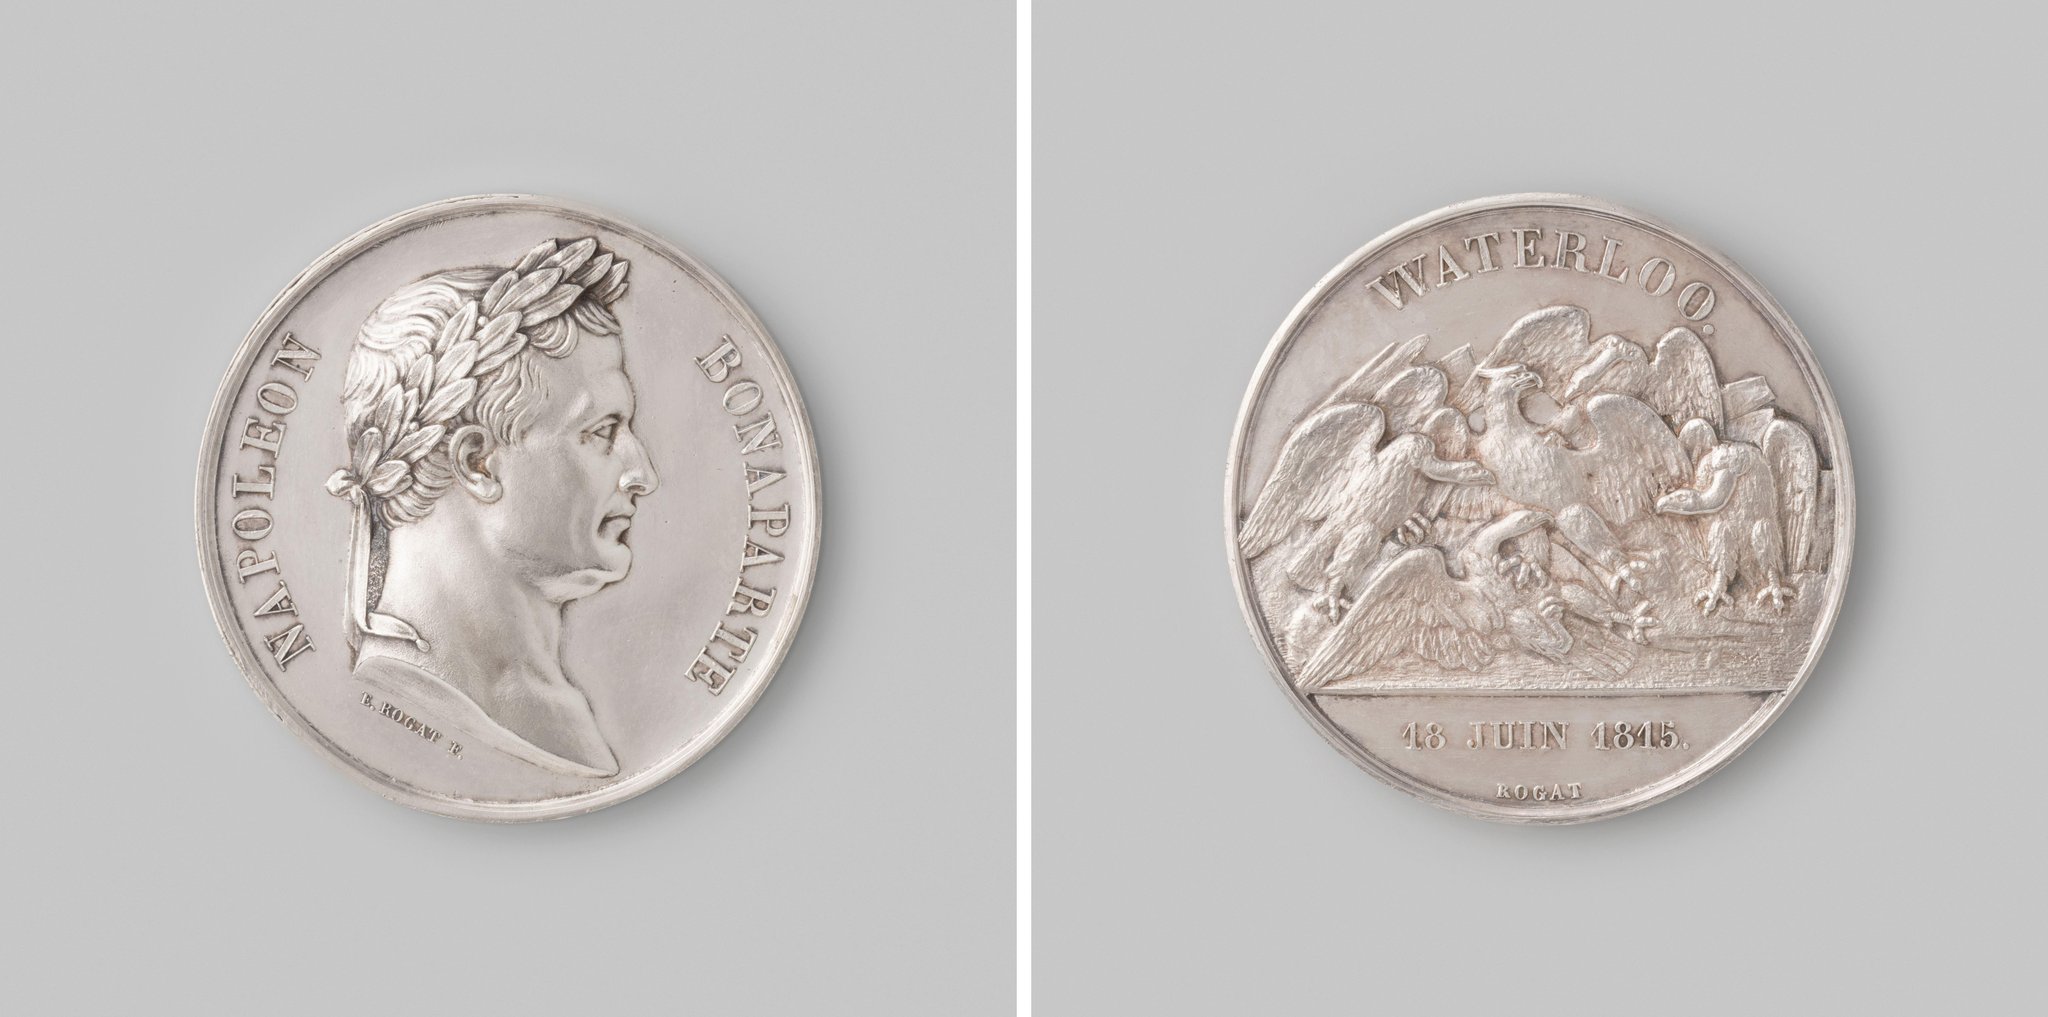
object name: history medal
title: Slag bij Waterloo, ter ere van Napoleon I Bonaparte, keizer der Fransen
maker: emile rogat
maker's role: medailleur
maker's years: 1799-1852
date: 1815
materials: silver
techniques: striking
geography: paris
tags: napoleon i (emperor of the french), waterloo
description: Zilveren penning. Voorzijde: borststuk man met lauwerkrans binnen omschrift. Keerzijde: adelaar in gevecht met vier gieren binnen omschrift; afsnede: datering en signatuur.